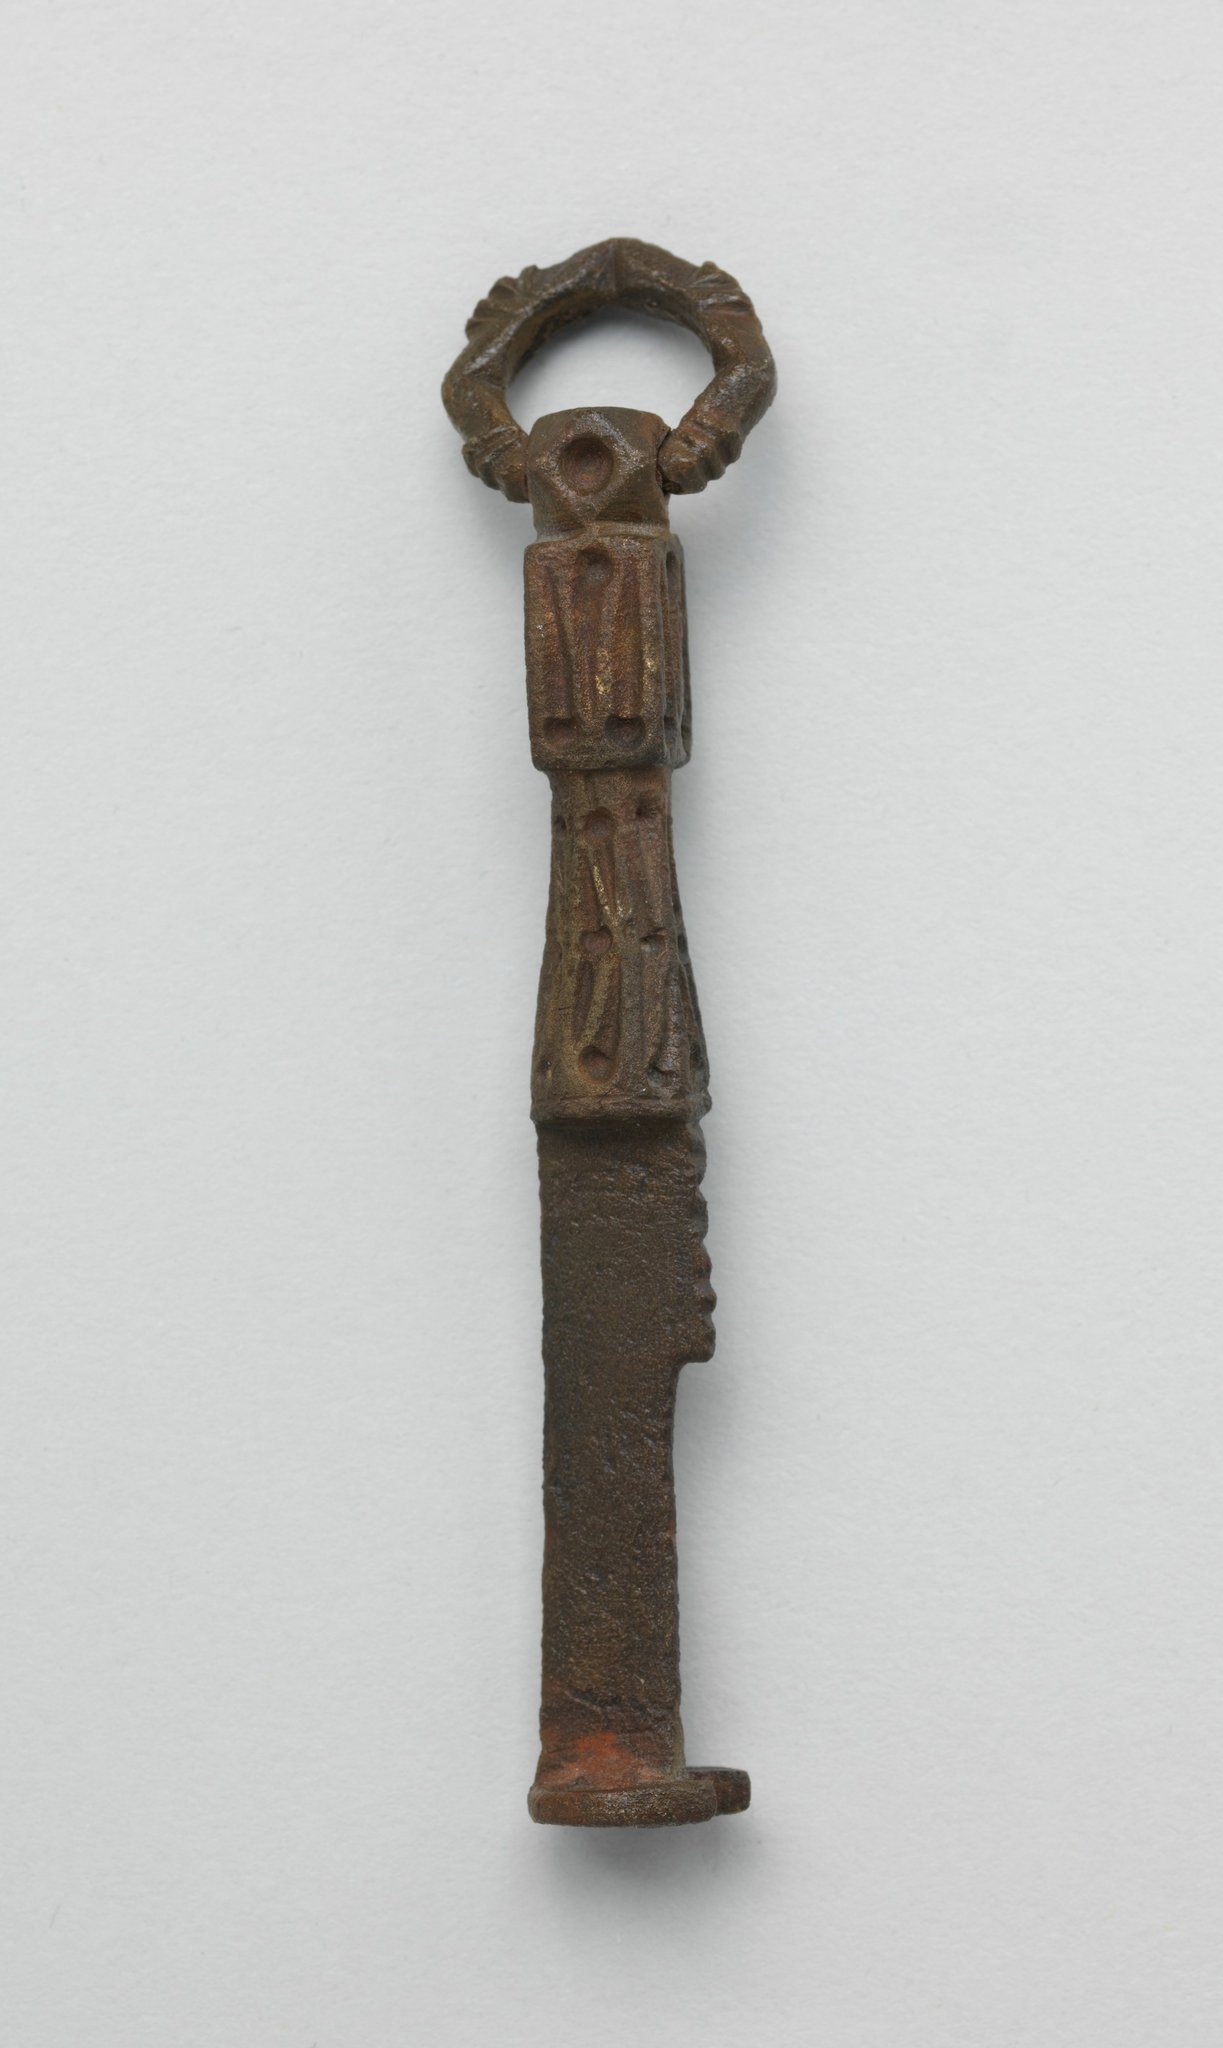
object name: key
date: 801-1000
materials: bronze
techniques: casting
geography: iran